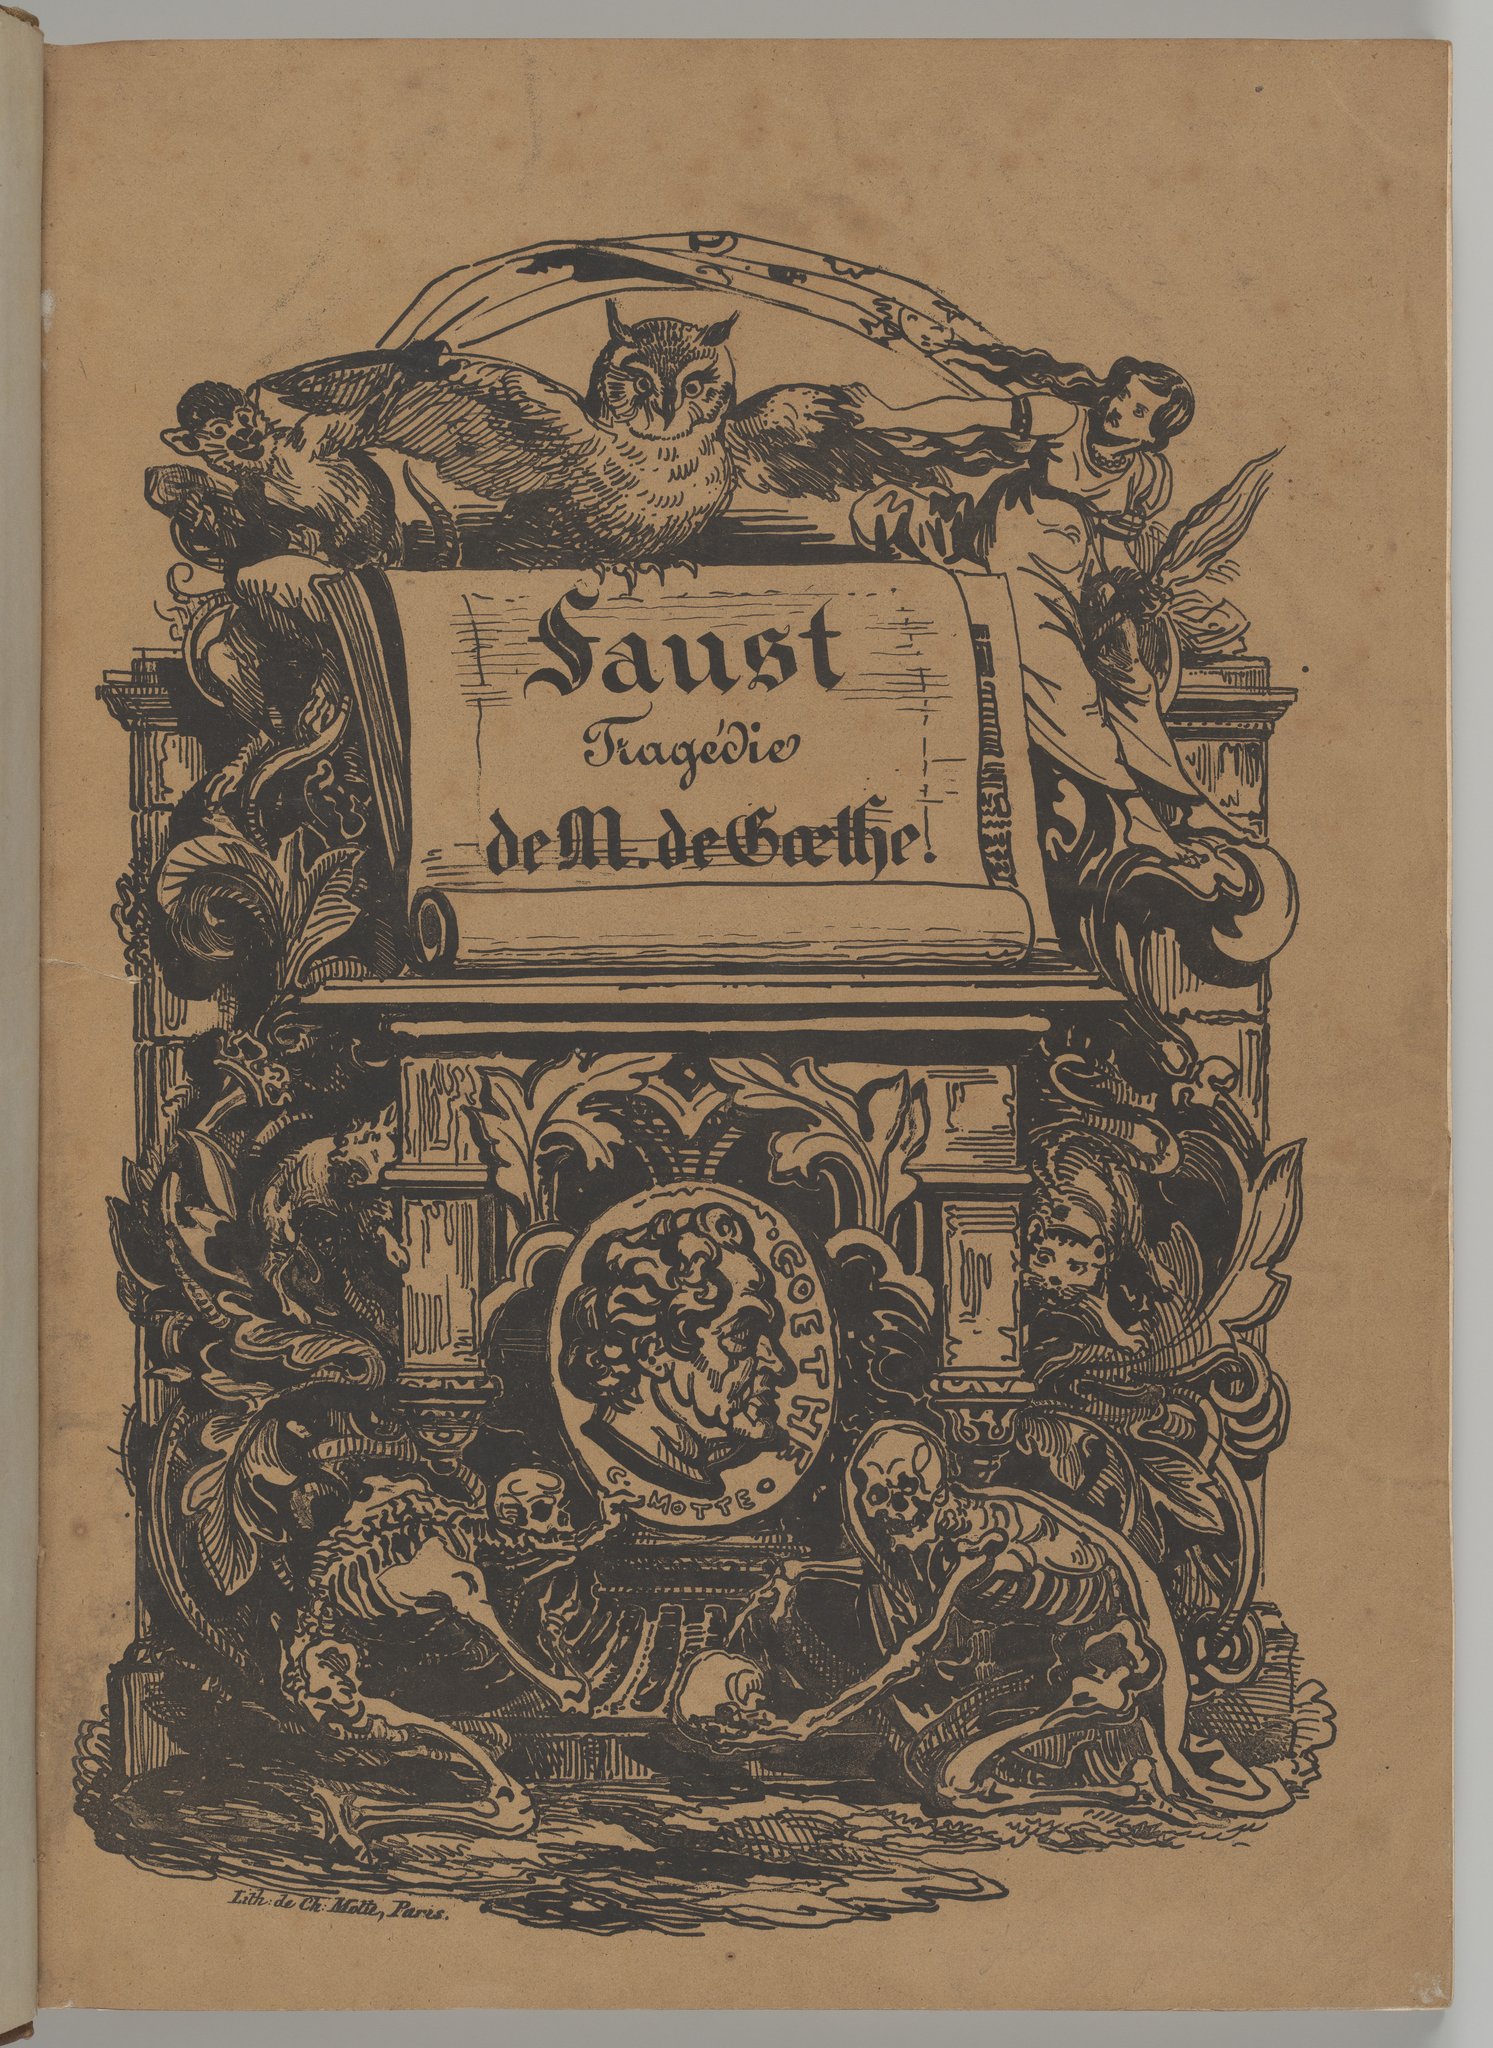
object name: book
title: Goethe's Faust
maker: johann wolfgang von goethe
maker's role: author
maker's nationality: german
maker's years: 1749-1832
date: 1828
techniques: lithograph